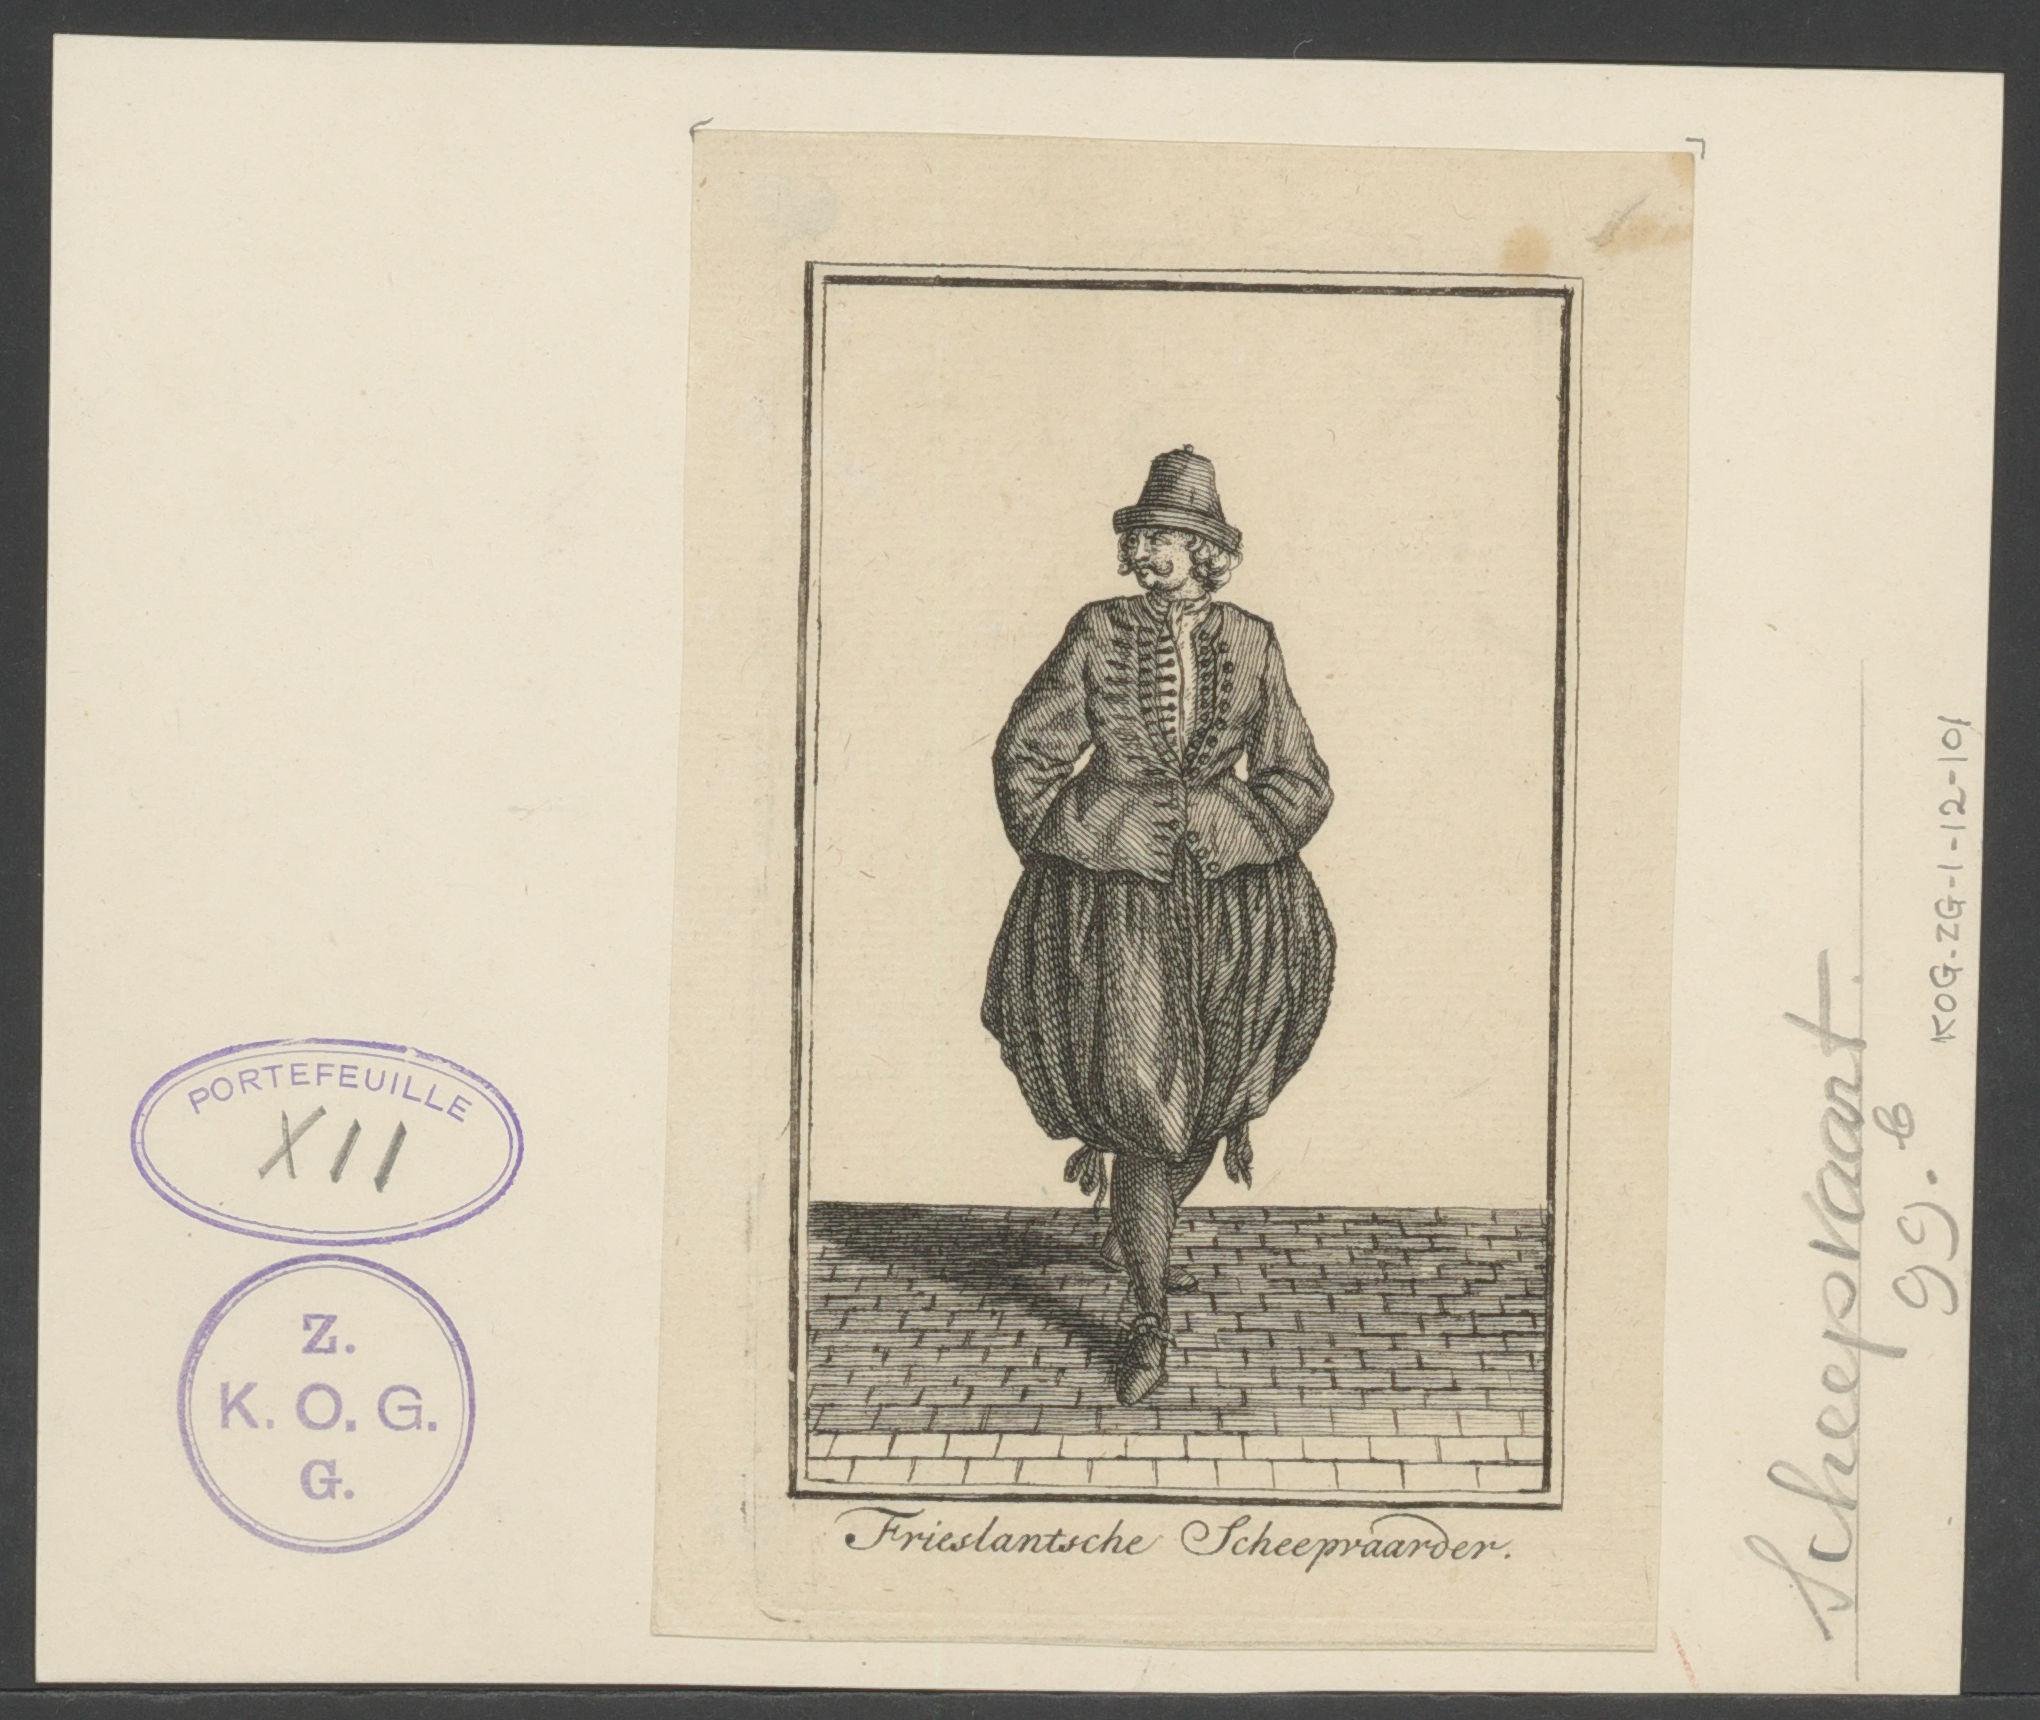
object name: costume print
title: Friese schipper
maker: Anonymous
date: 1690-1749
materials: paper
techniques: engraving, etching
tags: seaman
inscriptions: stamp, collector's mark: Lugt 1641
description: Staande man met de handen op zijn rug. Onderwerpsrubrieken binnen de Atlas Zeden en Gewoonten: Handel, Nijverheid en Verkeer, Scheepsvaart.